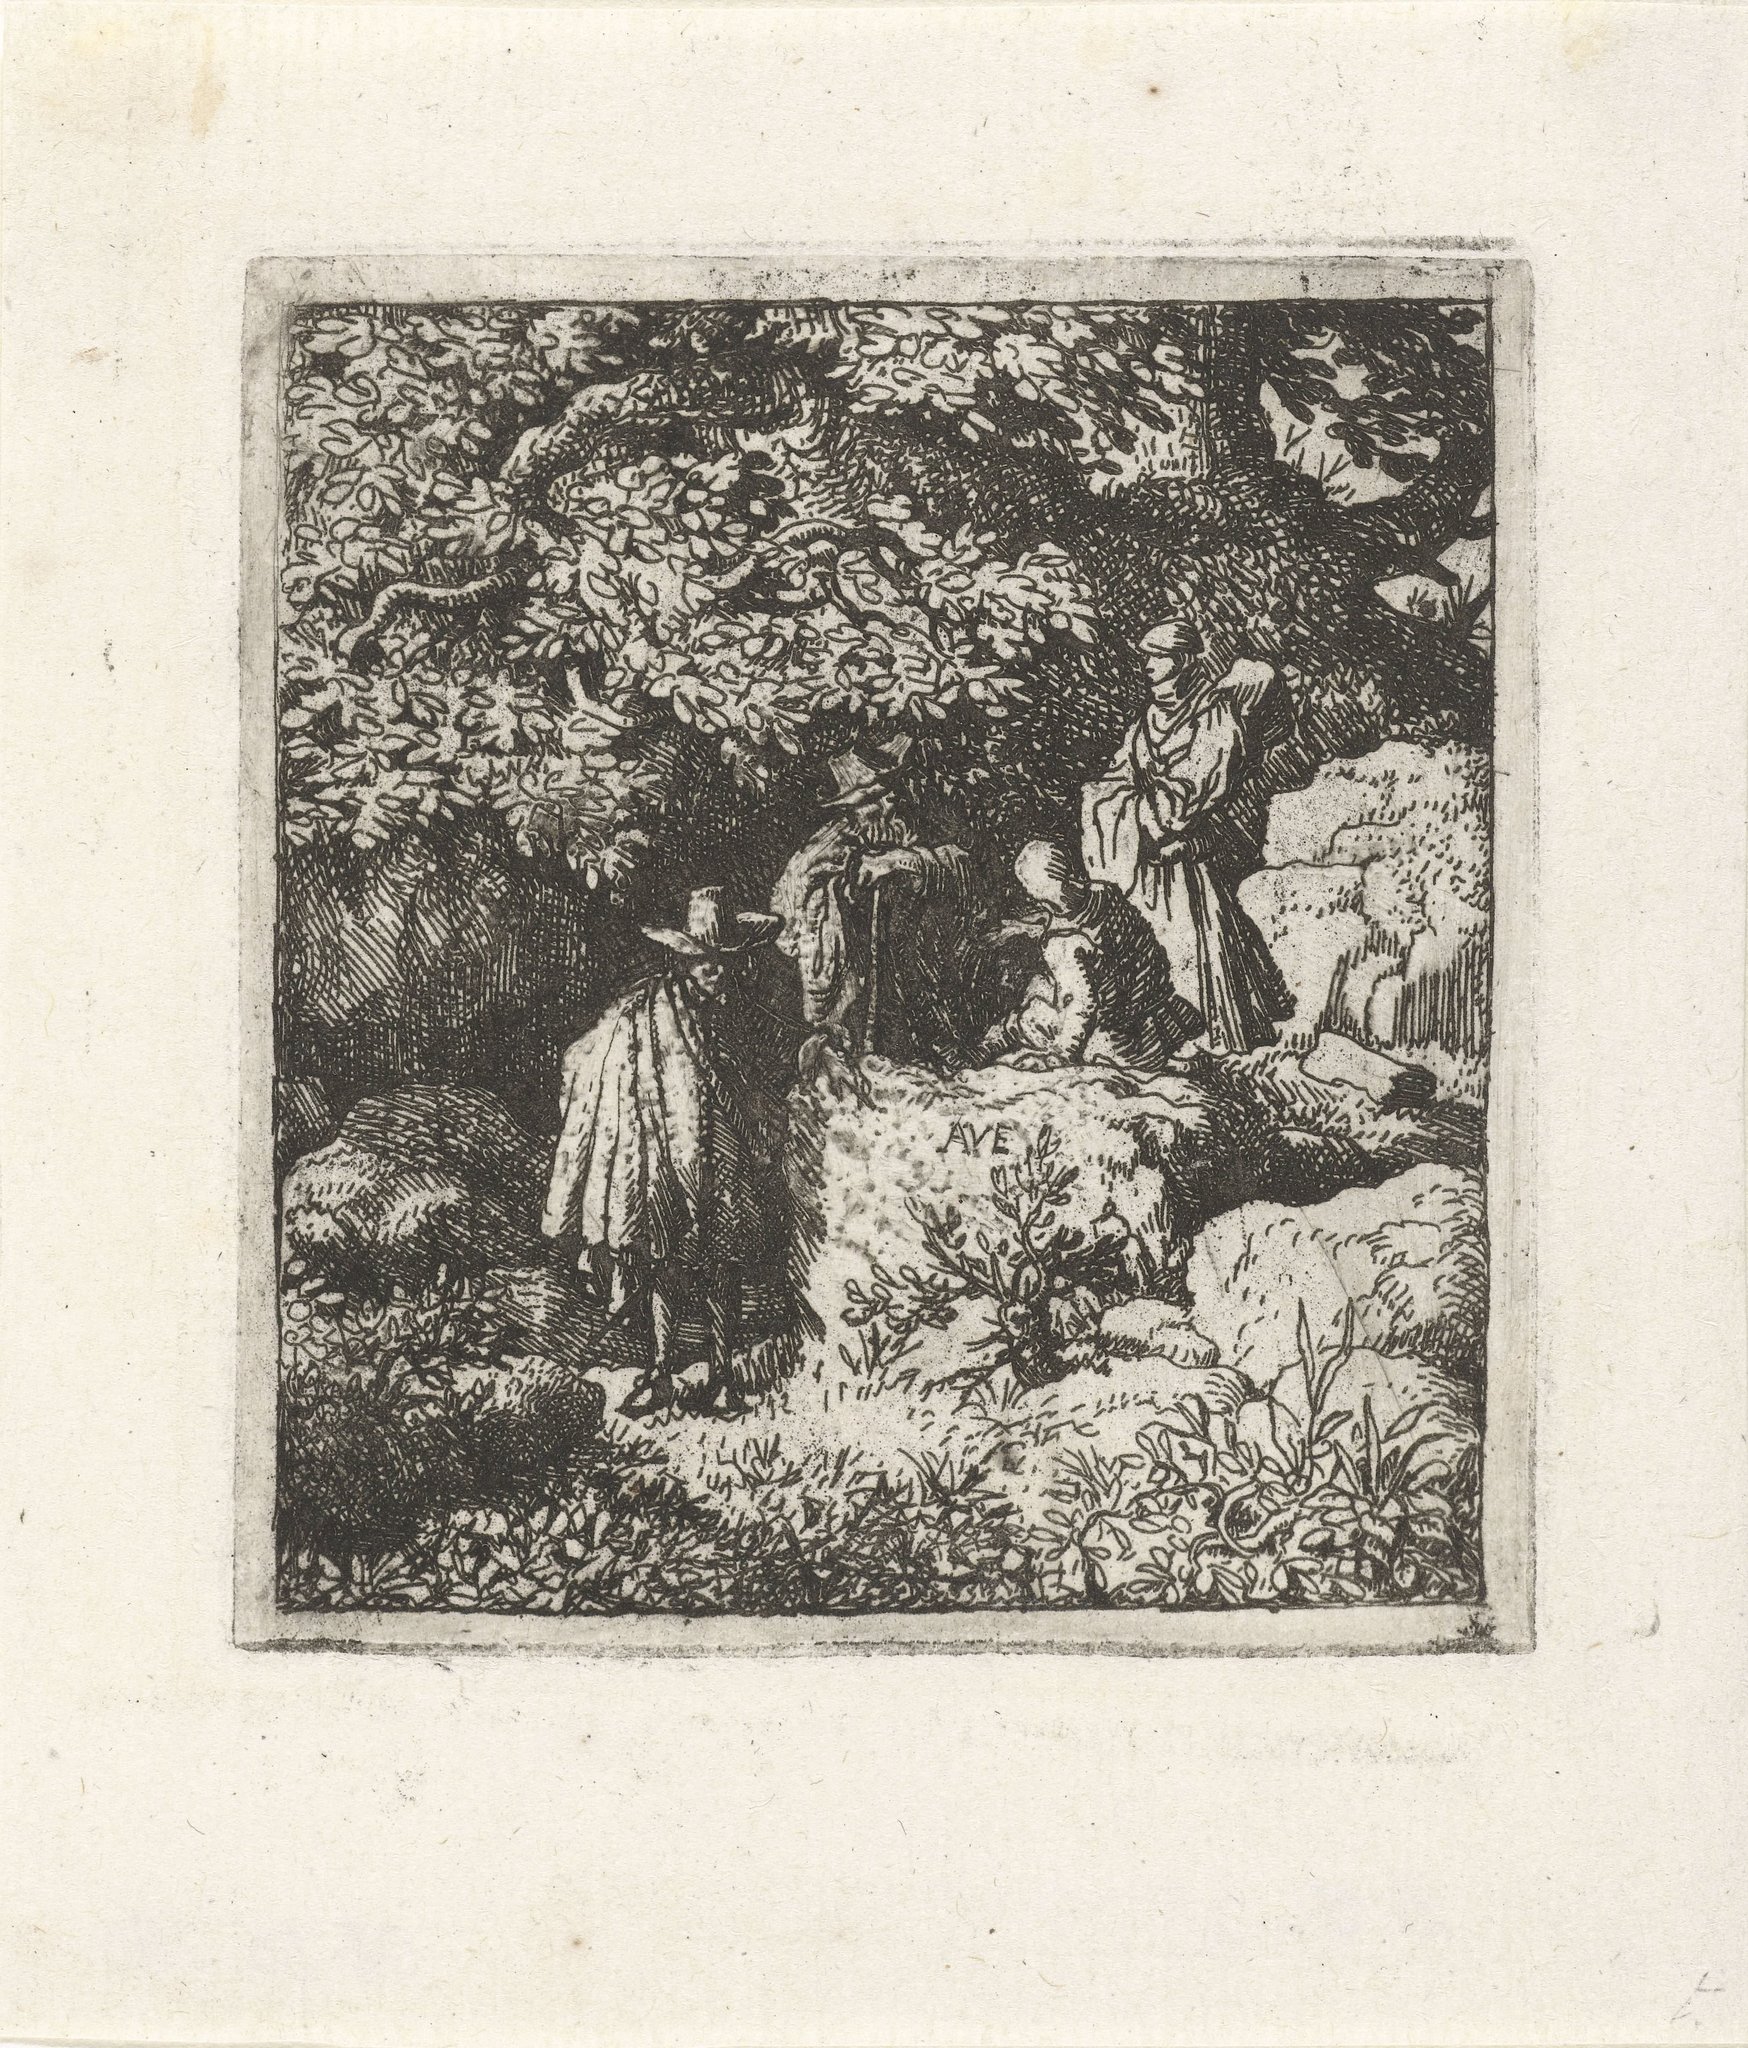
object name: print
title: Vier figuren onder een boom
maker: allaert van everdingen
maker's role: draughtsman, painter, print maker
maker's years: 1621-1675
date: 1631-1675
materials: paper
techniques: etching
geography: netherlands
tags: landscapes (+ landscape with figures, staffage)